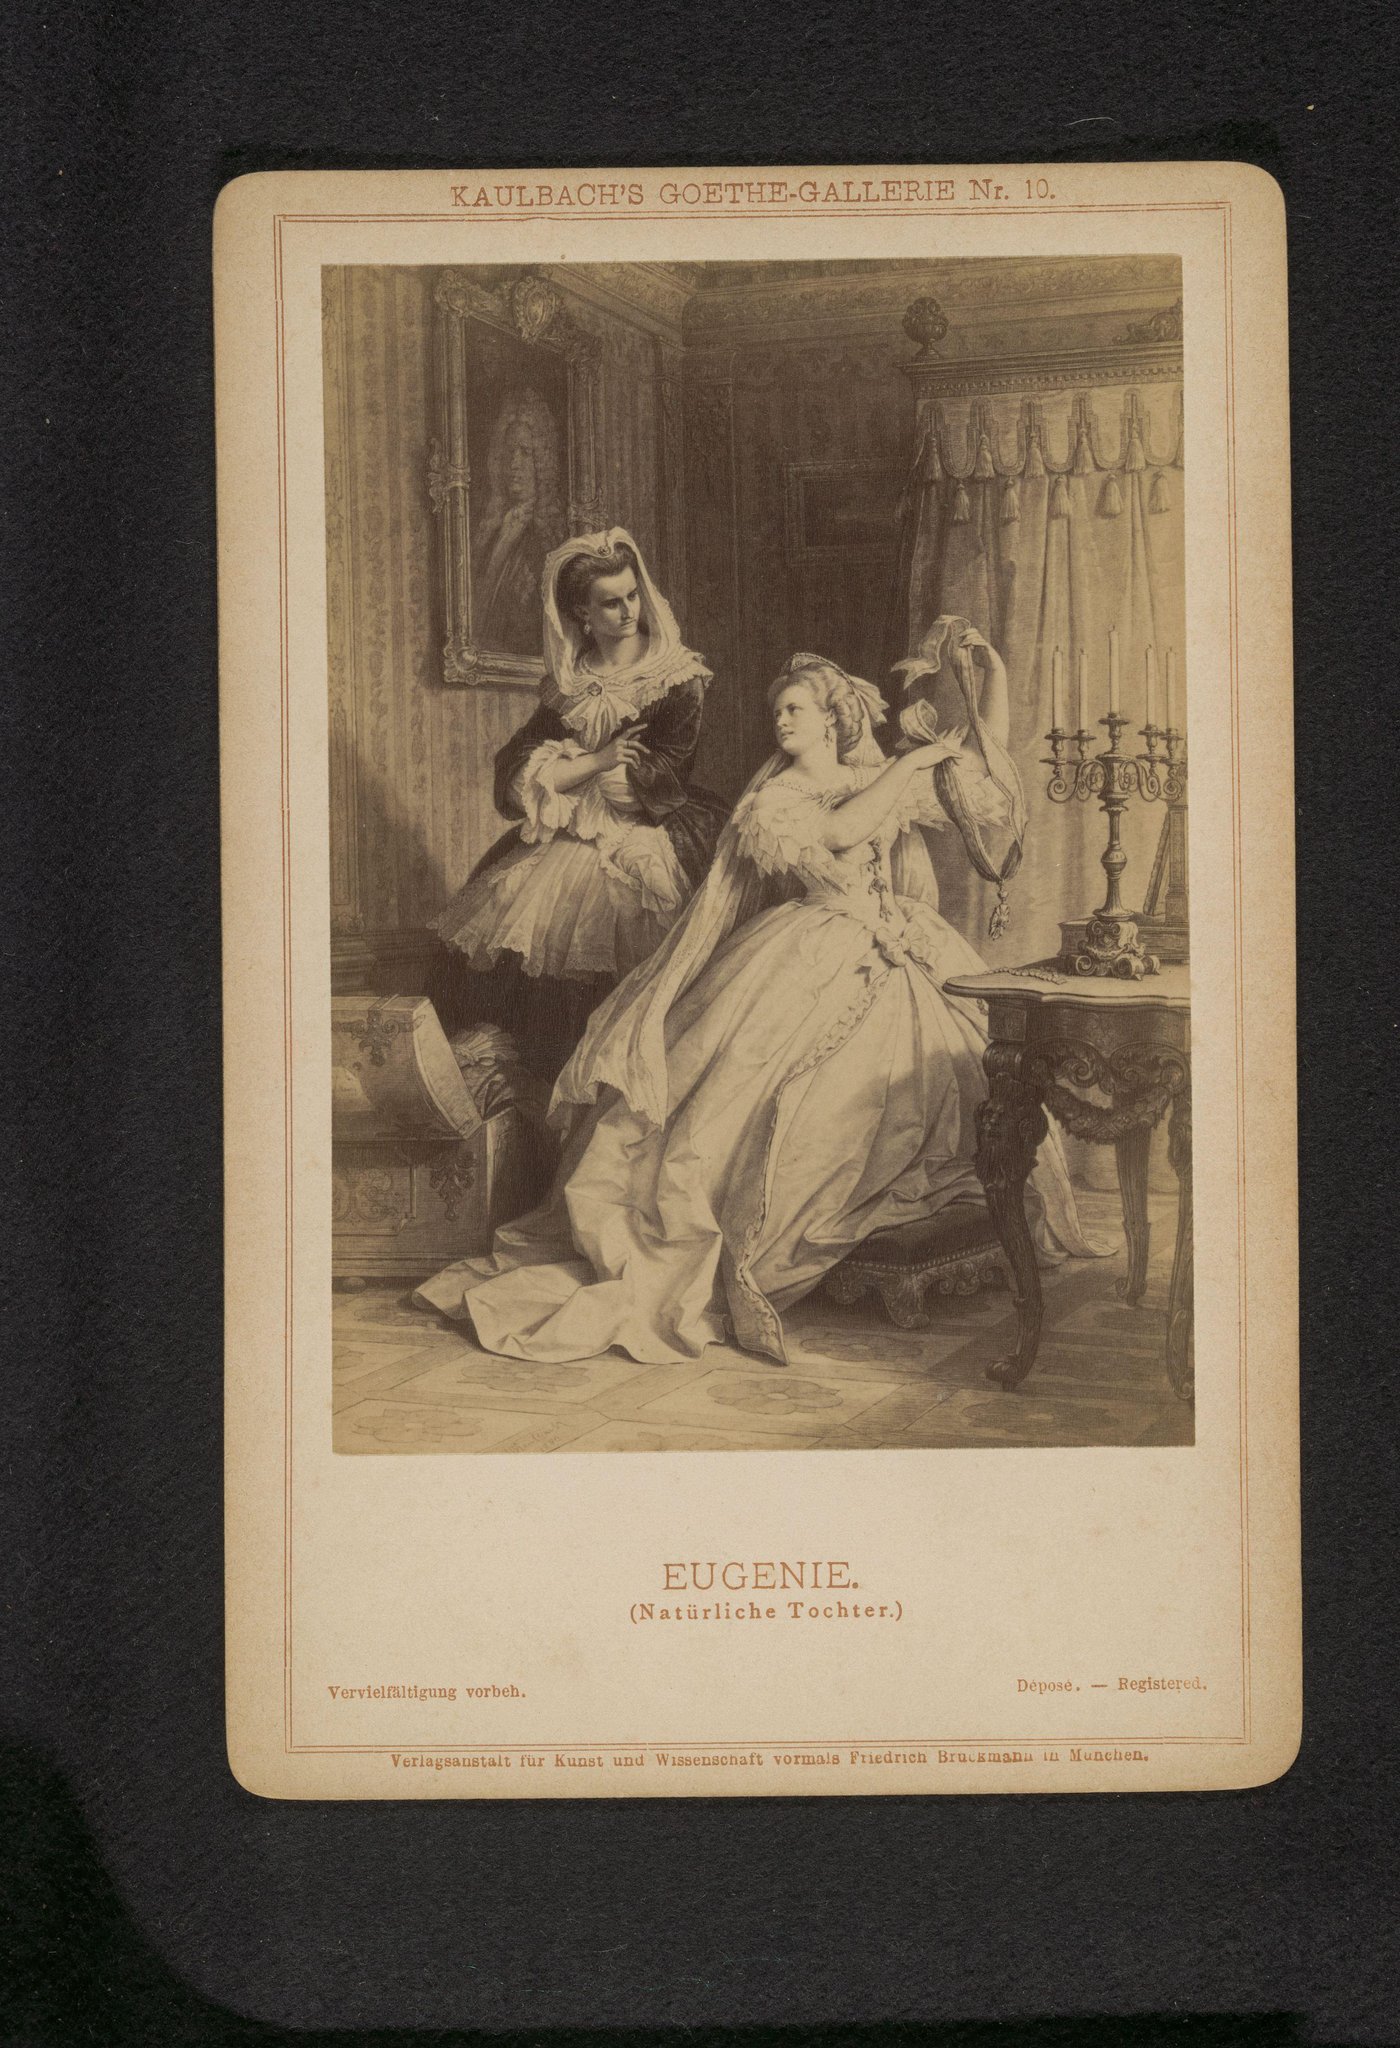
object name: photograph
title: Eugenie (Natürliche Tochter)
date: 1880-1885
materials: photographic support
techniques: albumen print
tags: adult man, literary characters and objects, painting, drawing and the graphic arts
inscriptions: inscription: ‘Kaulbach's Goethe-Gallerie Nr. 10’, name: ‘Friedrich Bruckmann's Verlag/ München’, inscription: ‘Vervielfältigung vorbeh. Déposé - Registered./ Verlagsanstalt für Kunst und Wissenschaft vormals Friedrich Bruckmann in München.’, annotation: ‘24.12.94’